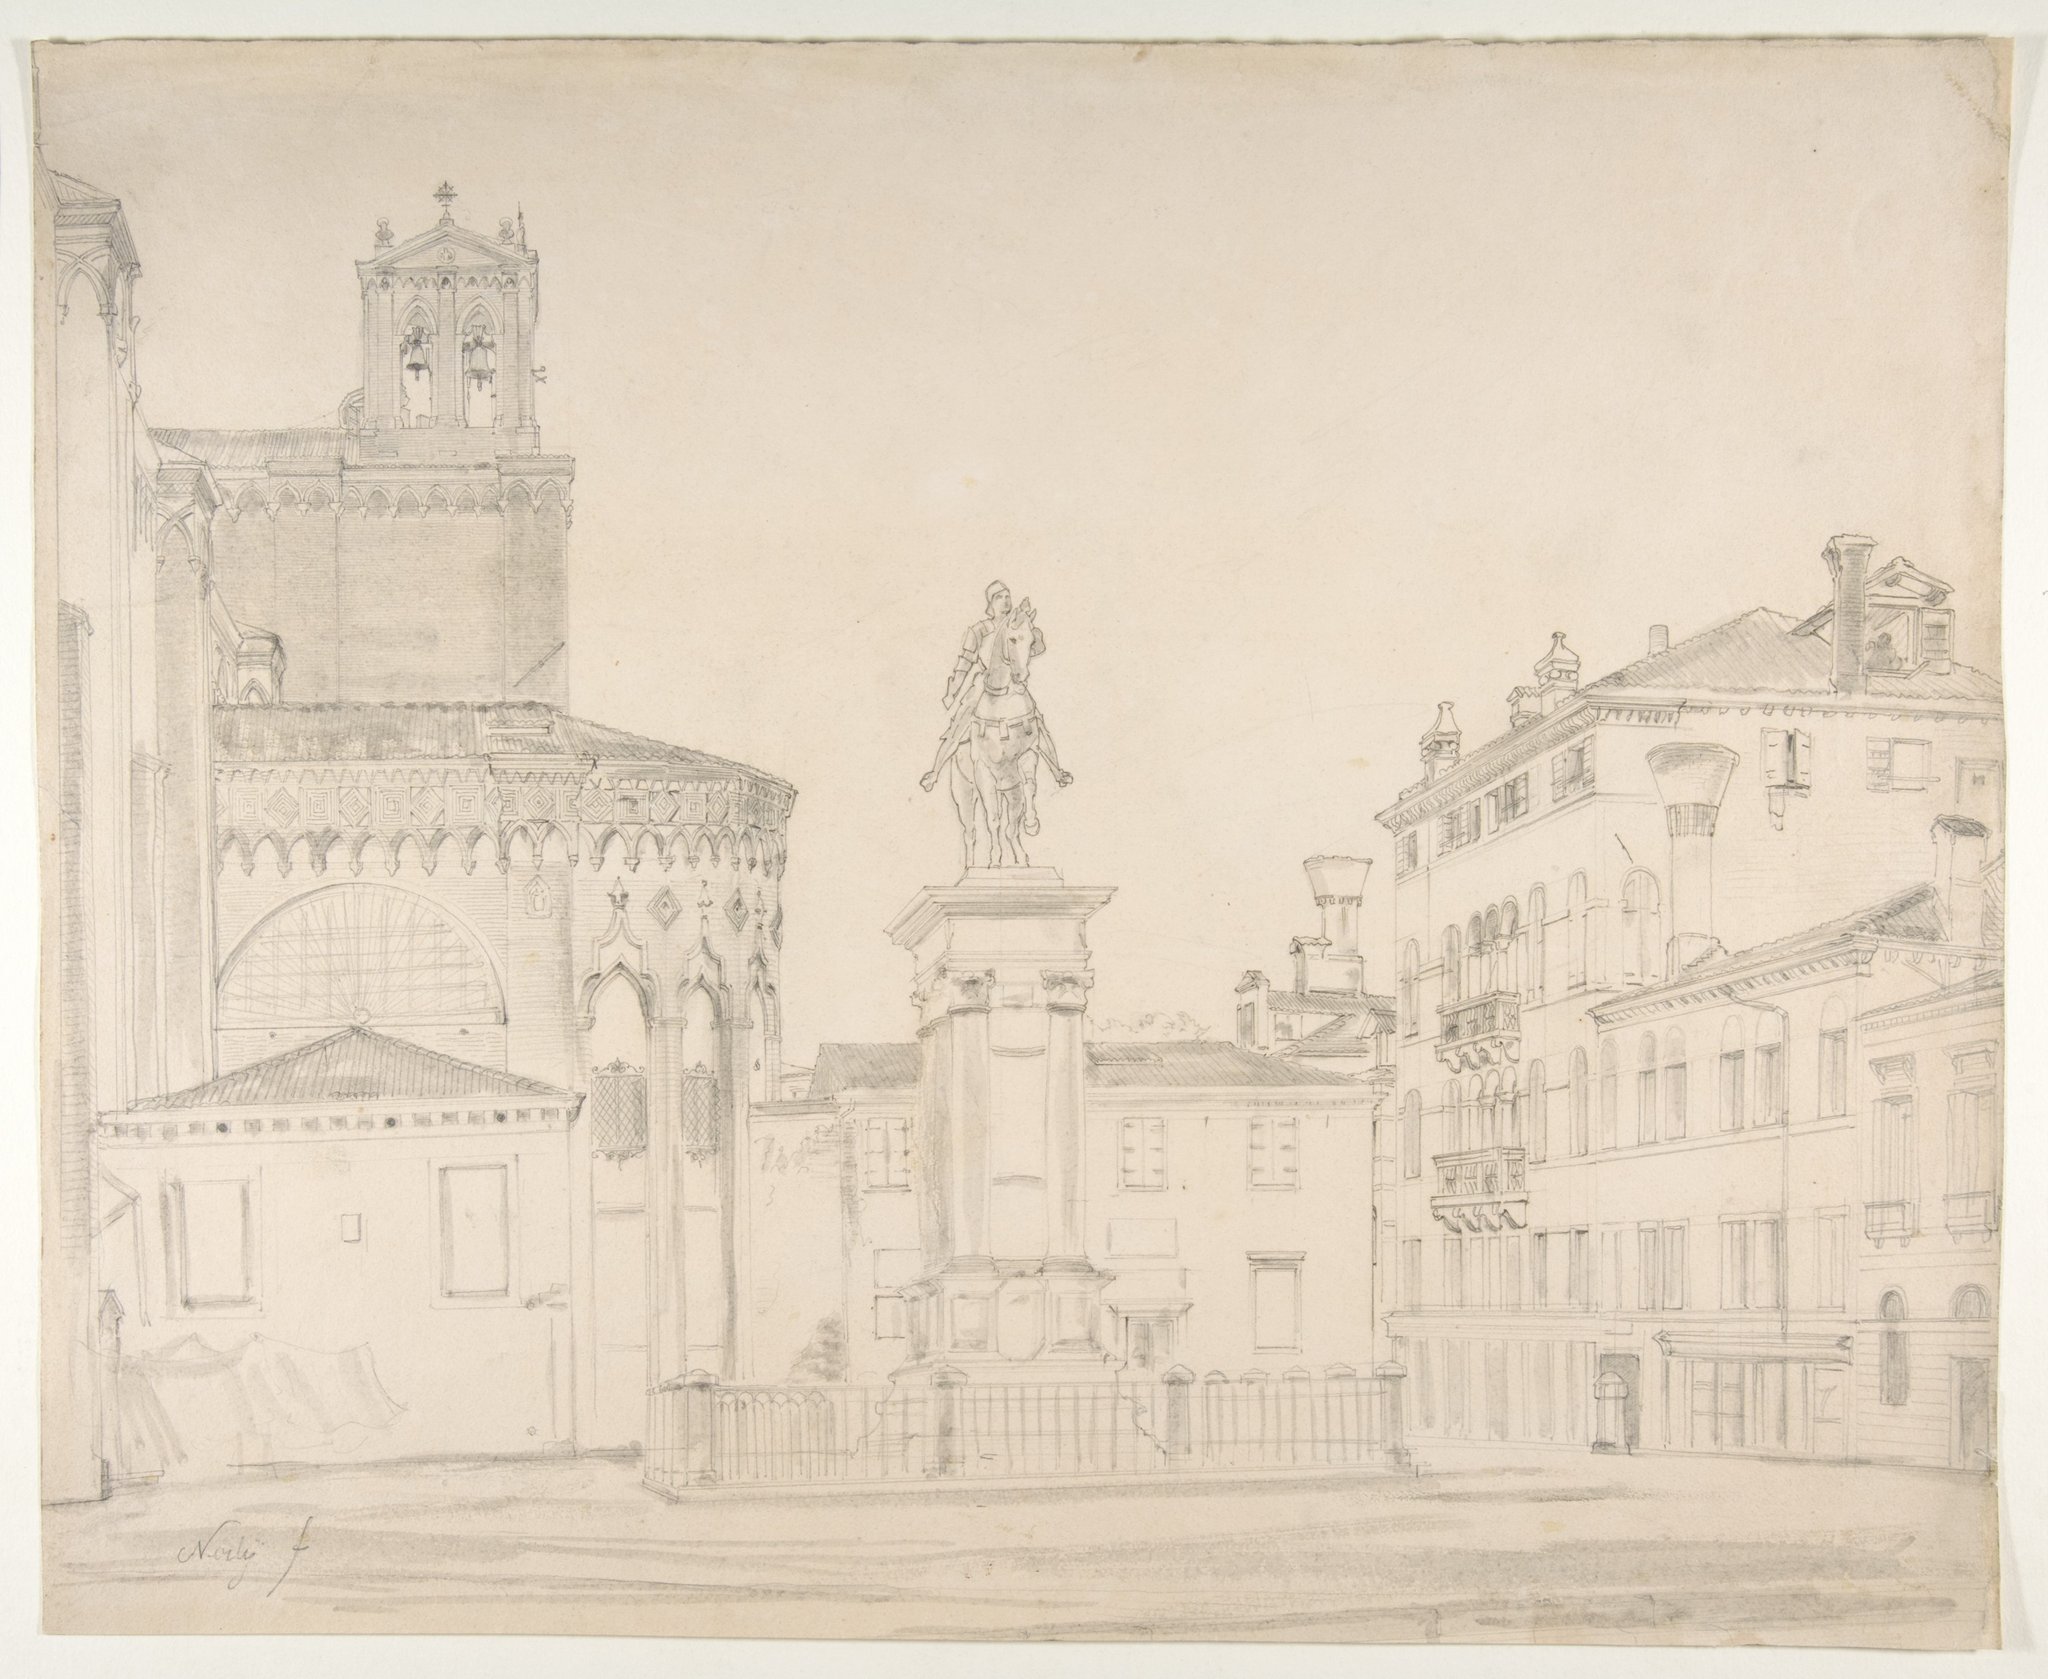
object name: drawing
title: View of the South side of the church of Santi Giovanni e Paolo in Venice, with Verrocchio's statue of Bartolomeo Colleoni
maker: friedrich nerly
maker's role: artist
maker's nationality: german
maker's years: 1807-1878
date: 1807-1878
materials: graphite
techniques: brush, wash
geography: italy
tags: sculpture,churches,horses,venice